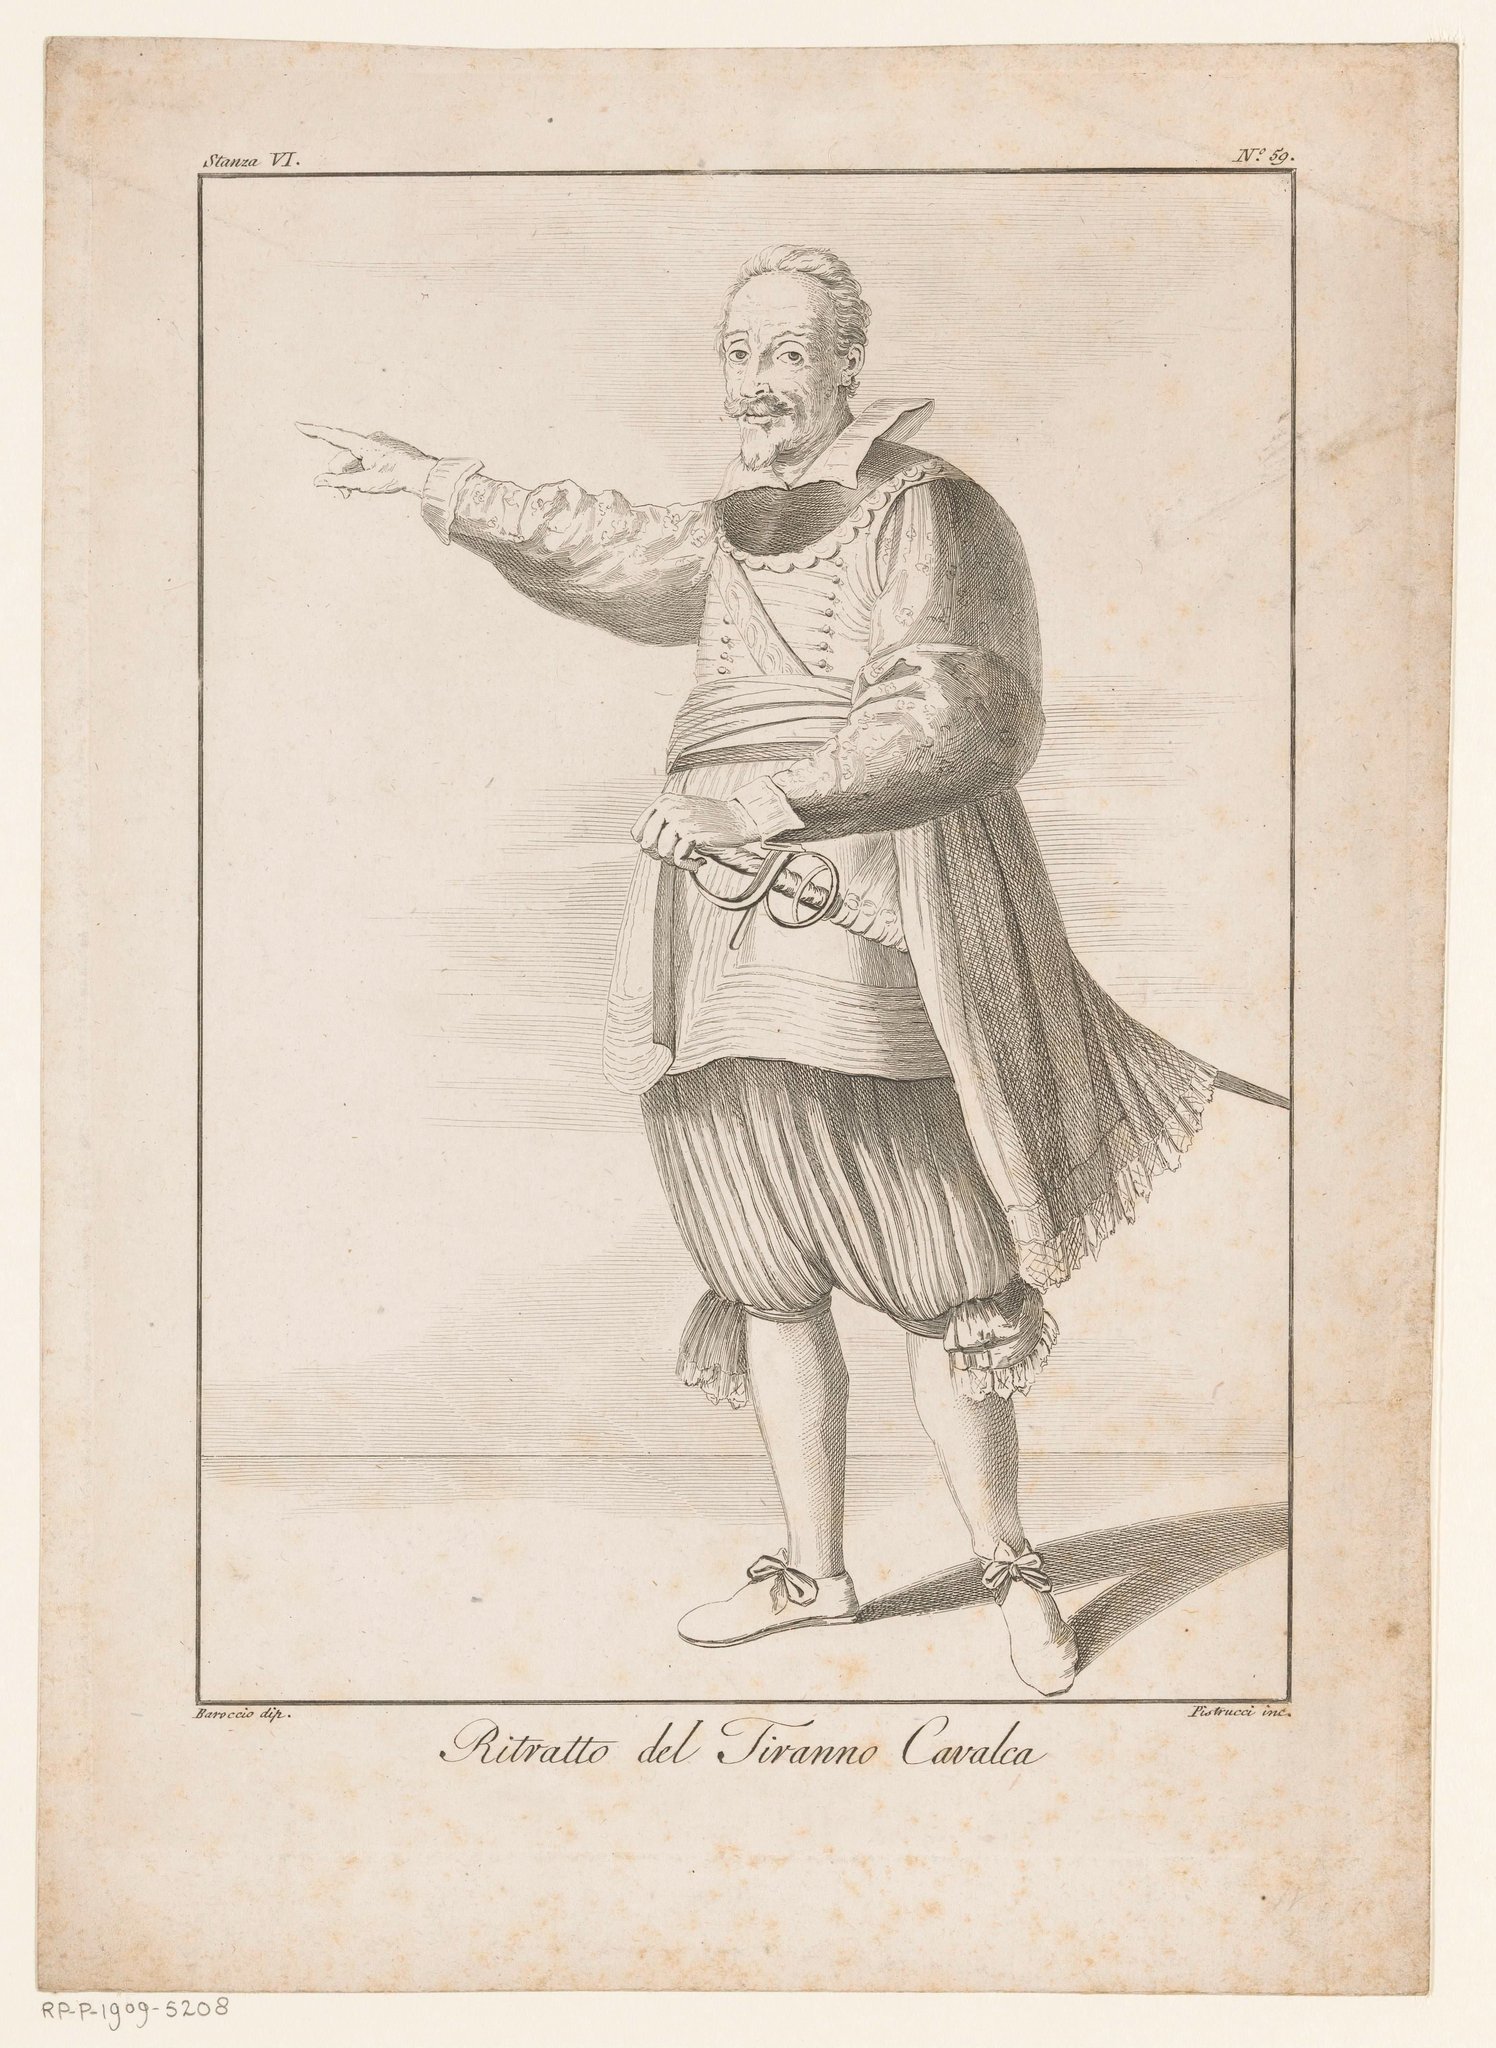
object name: print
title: Galerie Lucien Bonaparte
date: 1812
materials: paper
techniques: etching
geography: italy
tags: historical persons, hacking and thrusting weapons: sword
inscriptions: collector's mark: Lugt 2228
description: Deze prent maakt deel uit van de serie 'Choix de gravures à l'eau-forte d'après les peintures et les marbres de la galerie de Lucien Bonaparte', uitgegeven in 1812 te Londen. De serie bestaat uit prenten naar schilderijen die zich destijds bevonden in de collectie van Lucien Bonaparte. Destijds werd het schilderij beschreven als een portret van 'Tiranno Cavalca' en toegeschreven aan Federico Barocci. Tegenwoordig wordt het schilderij toegeschreven aan Justus Sustermans.